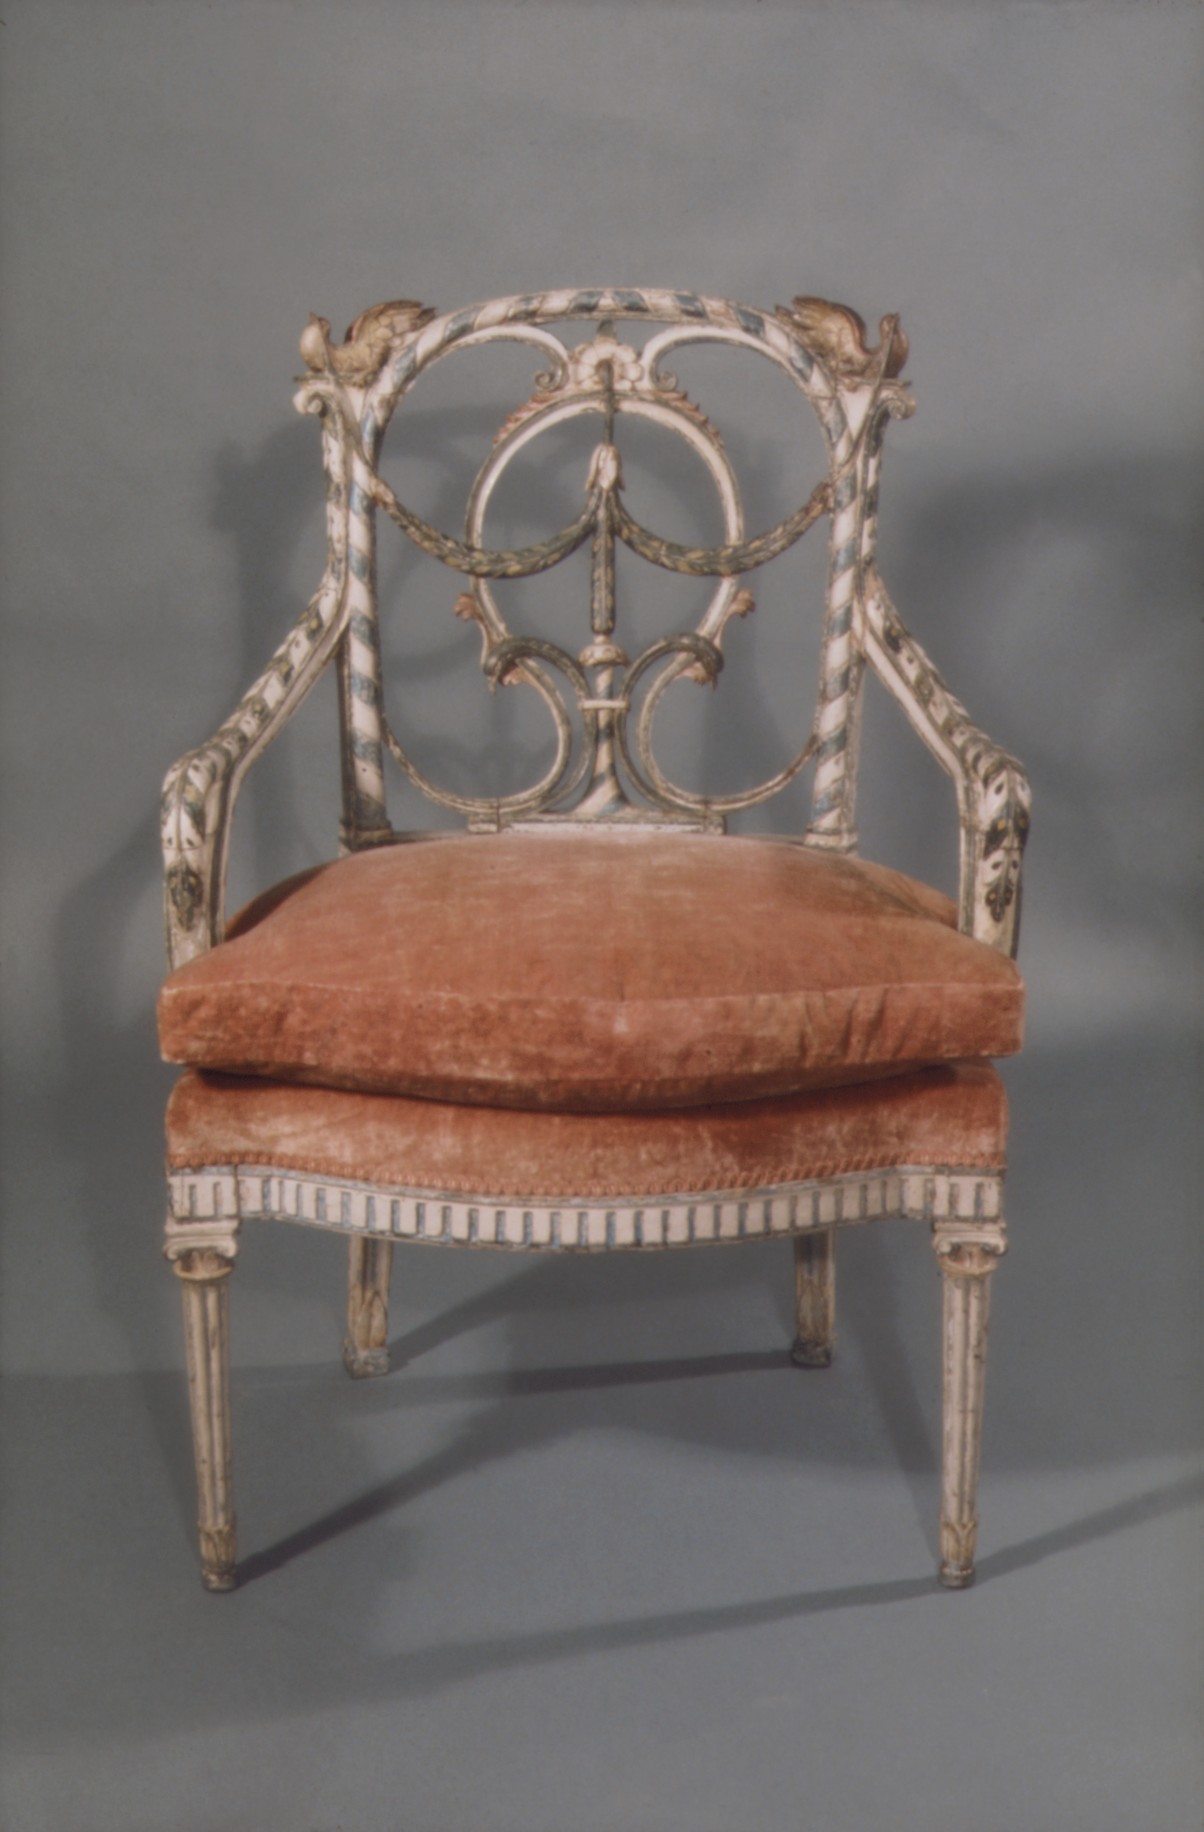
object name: armchair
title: Pair of armchairs (part of a set)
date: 1780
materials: cotton, linen, silk, velvet, wood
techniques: brocade, carving, polychrome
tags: birds